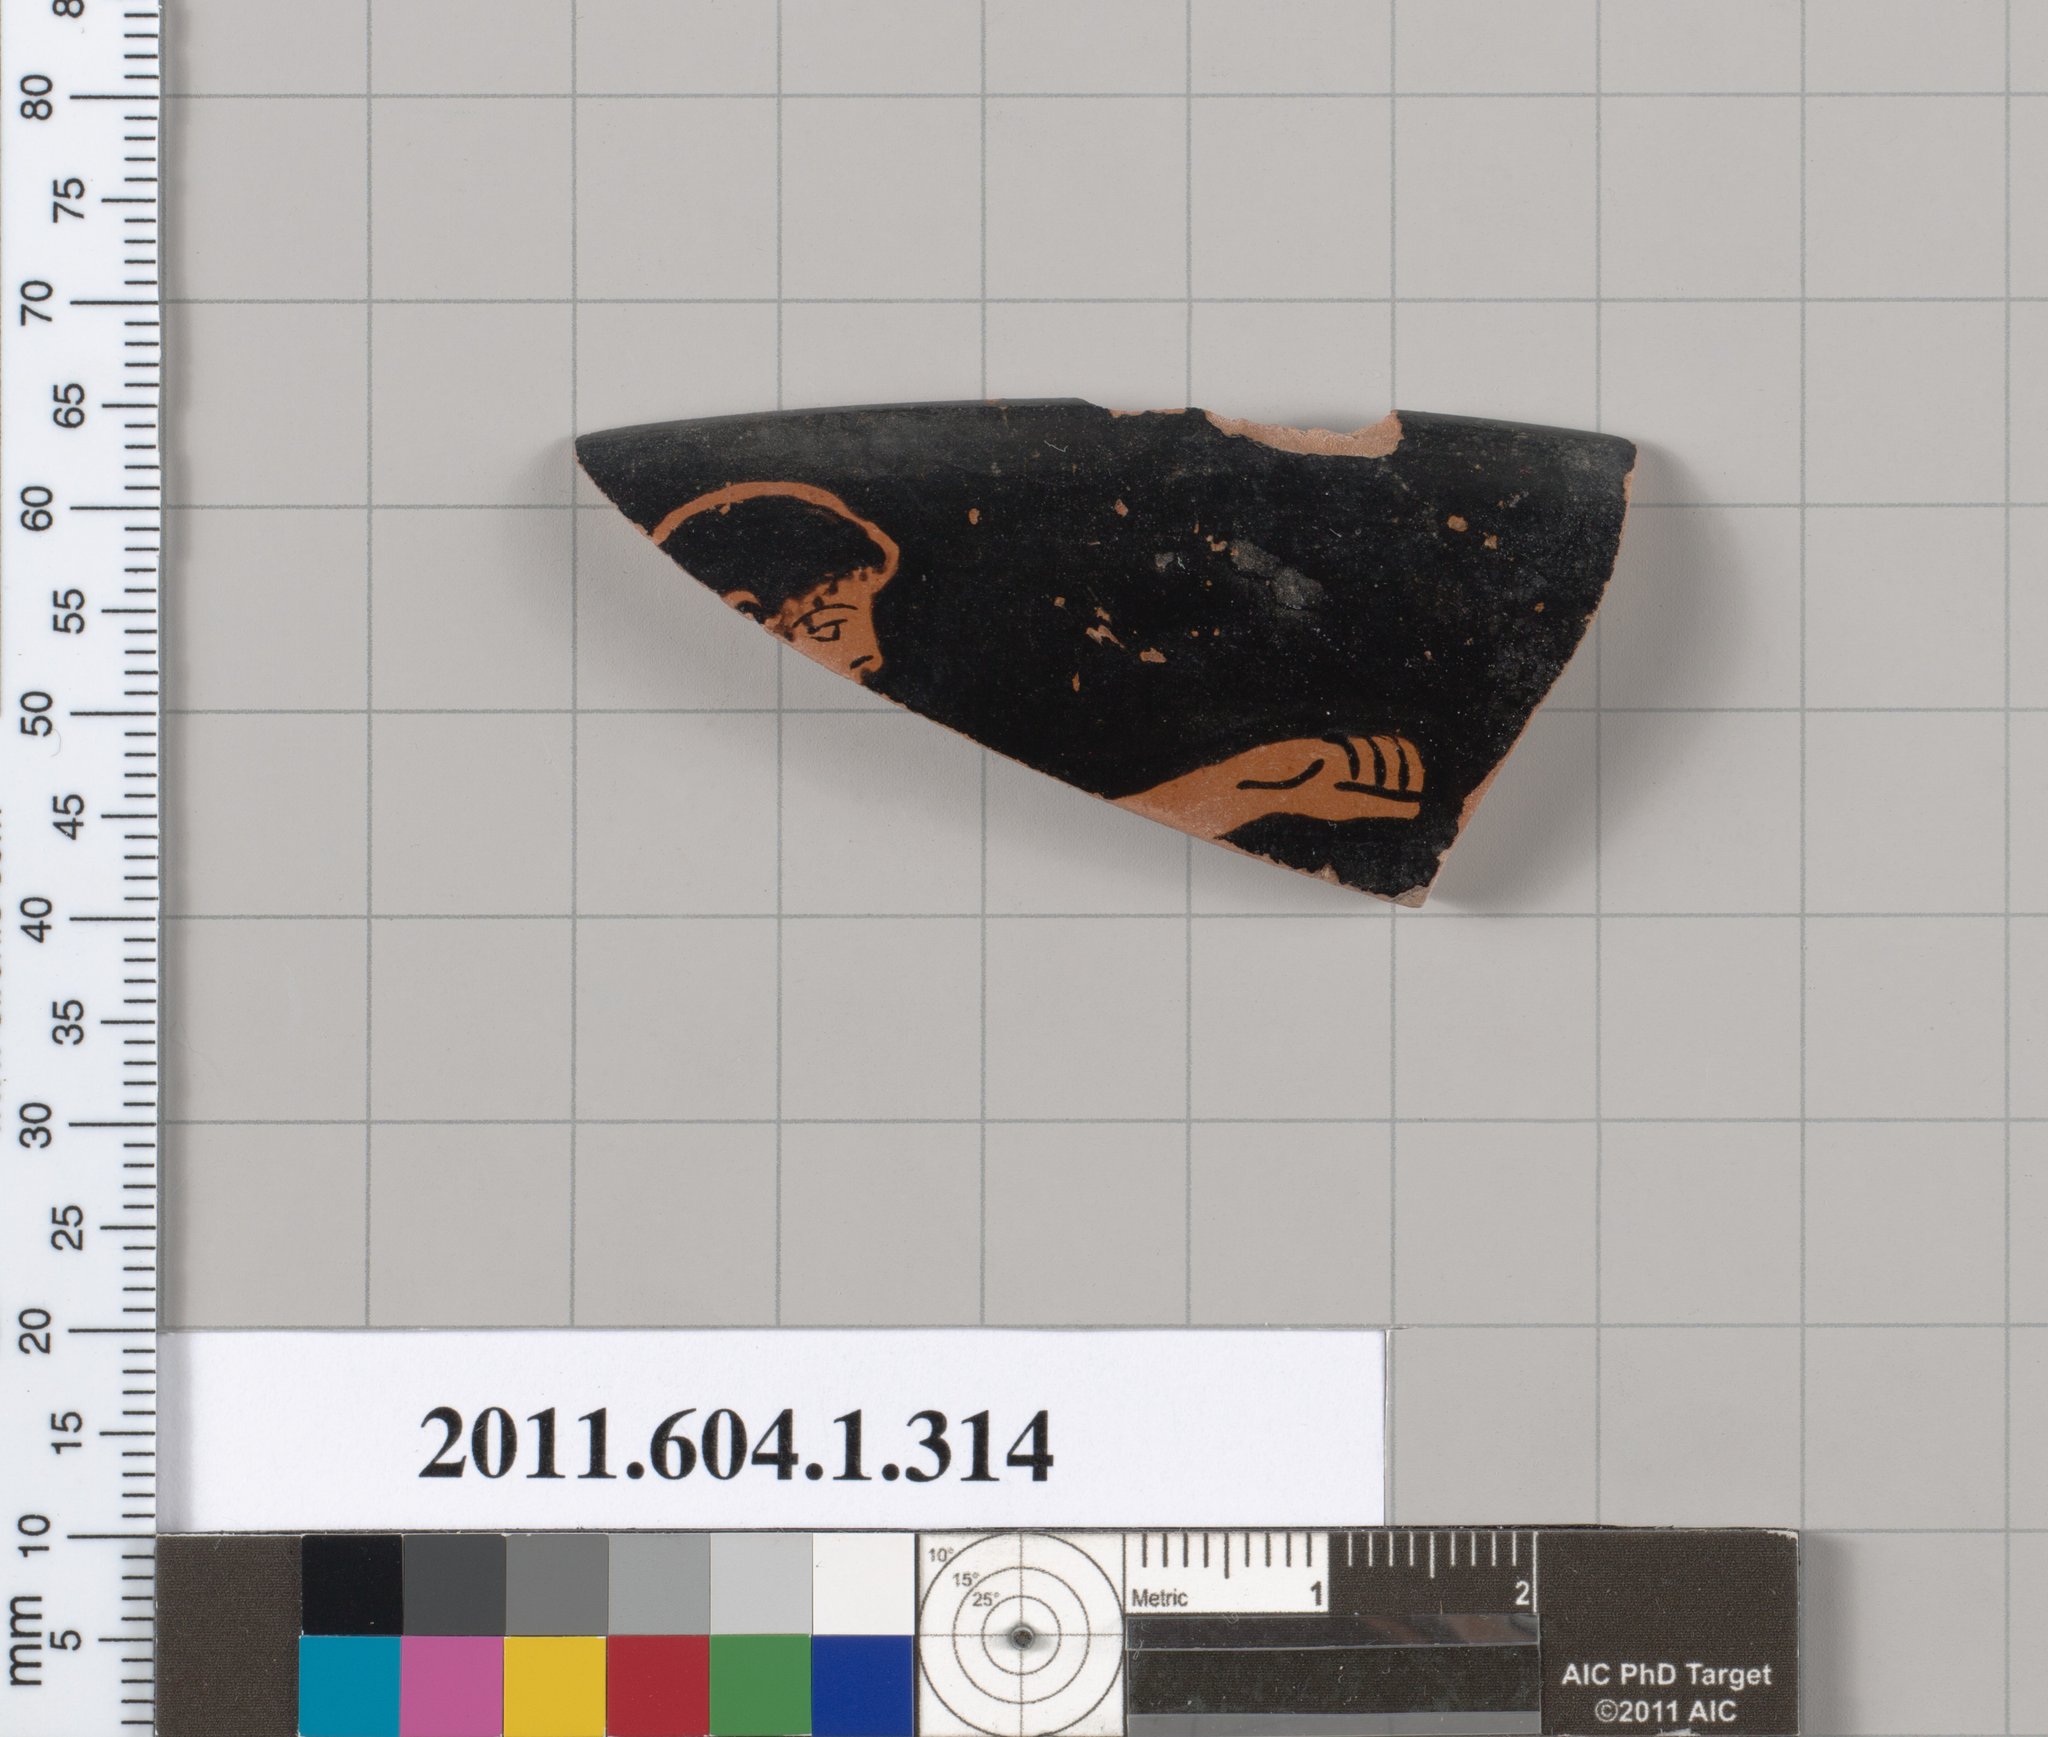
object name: kylix fragment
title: Terracotta rim fragment of a kylix (drinking cup)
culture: greek, attic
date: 475-451 BCE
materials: terracotta